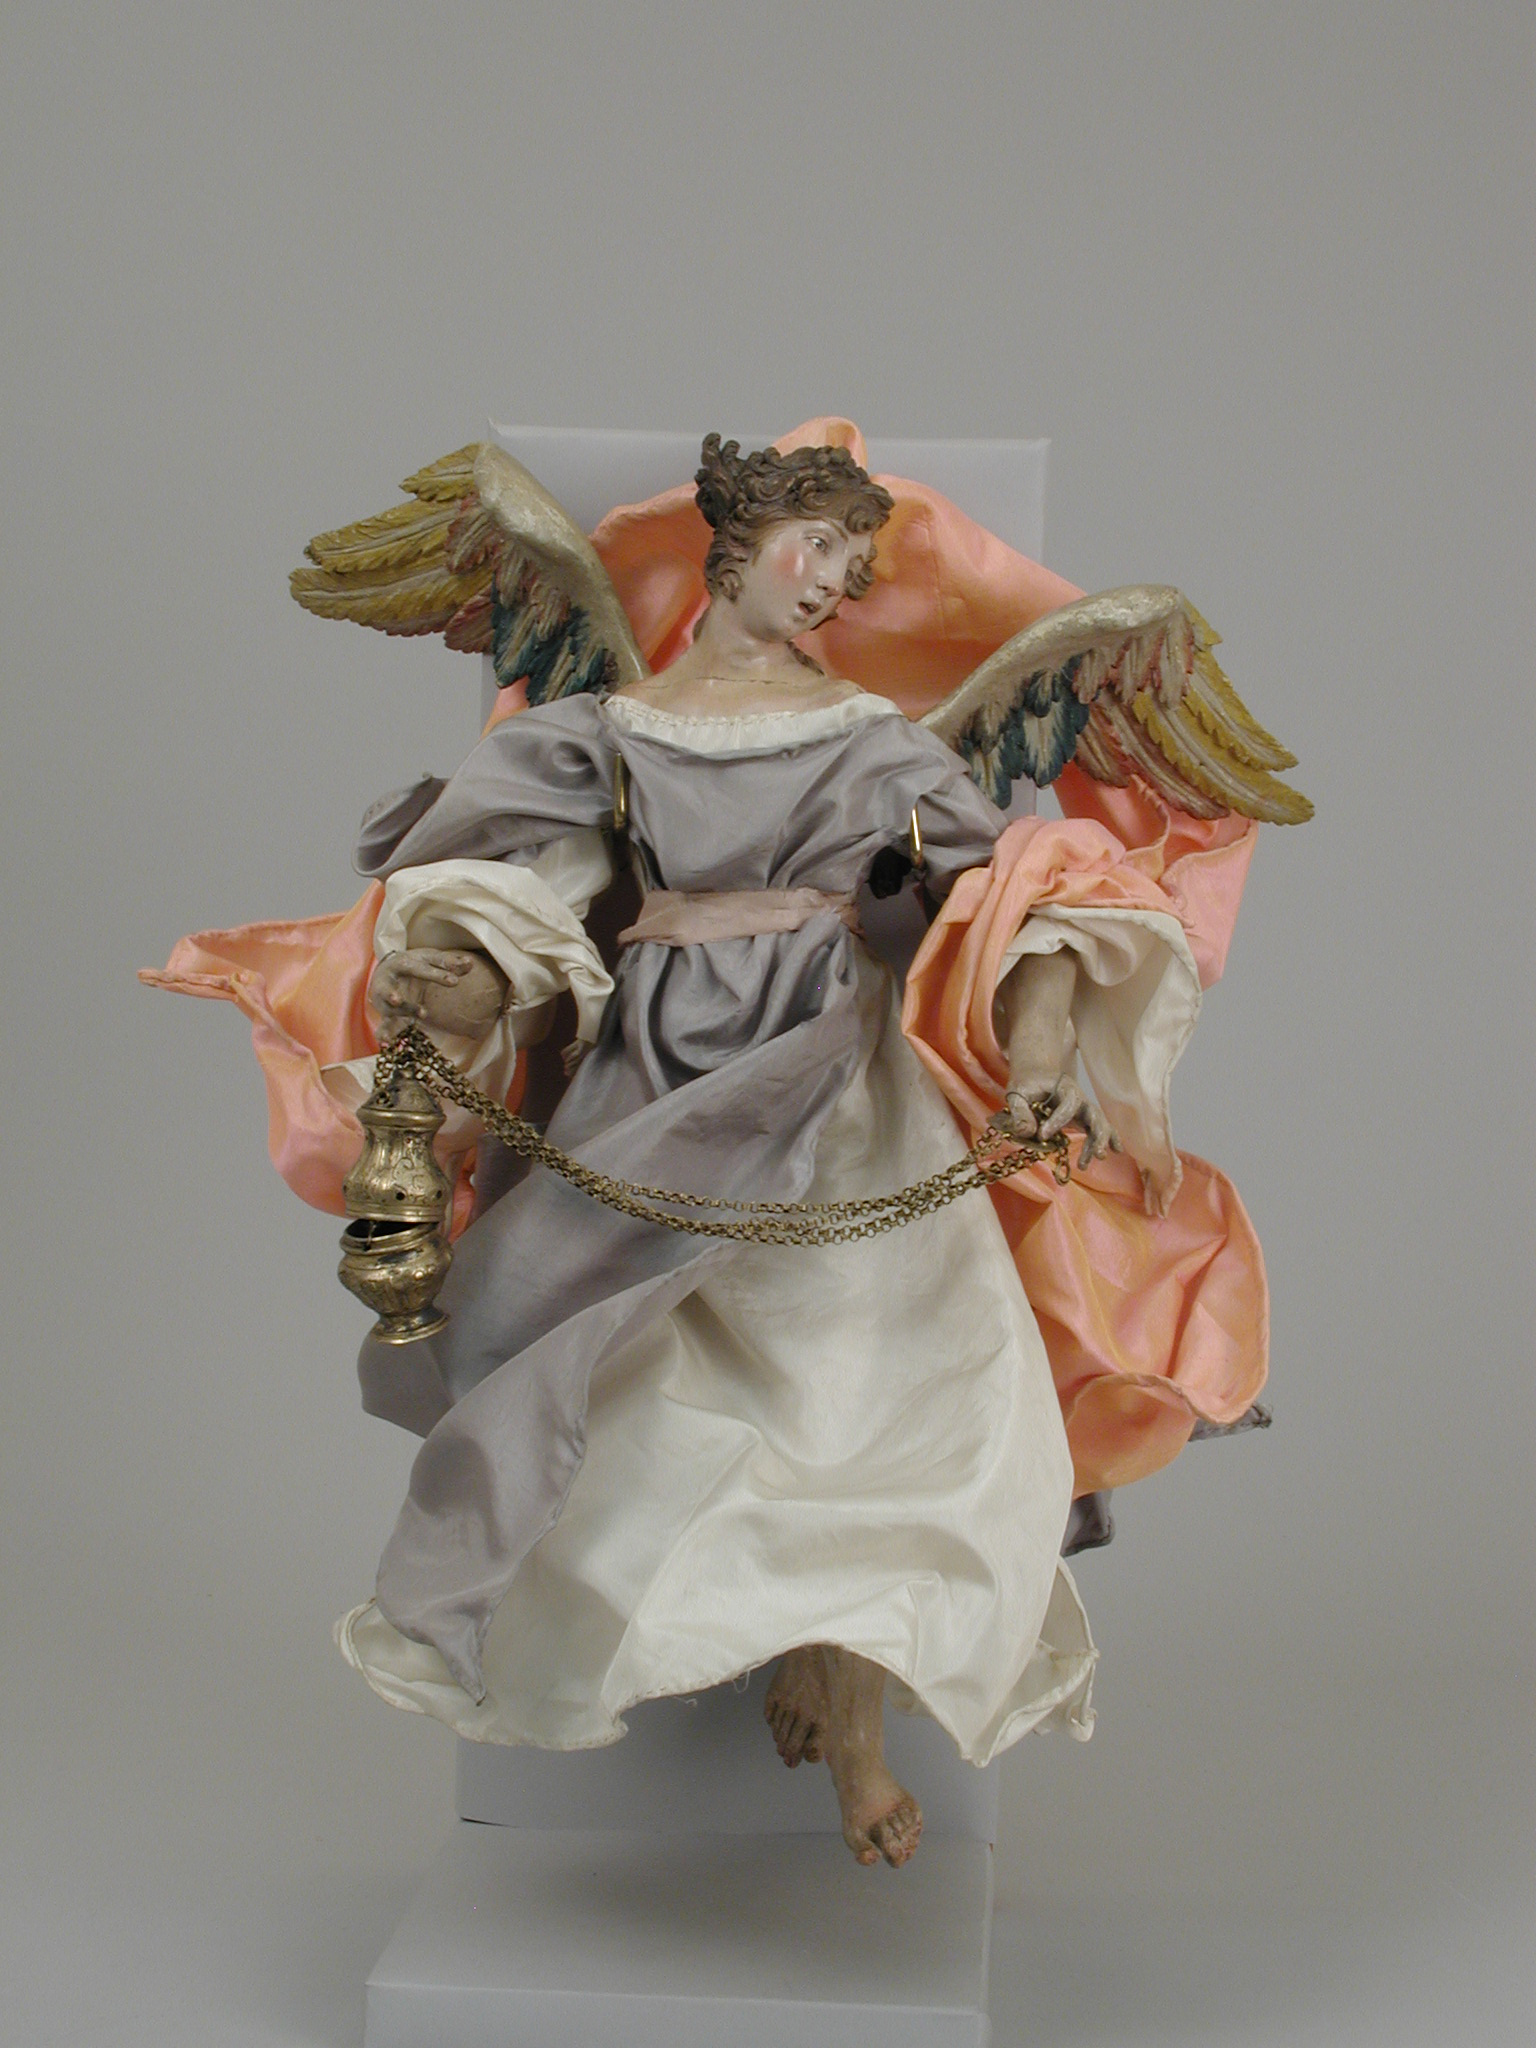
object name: crèche figure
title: Angel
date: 1751-1800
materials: terracotta, fiber, metal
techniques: polychrome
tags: angels,censers